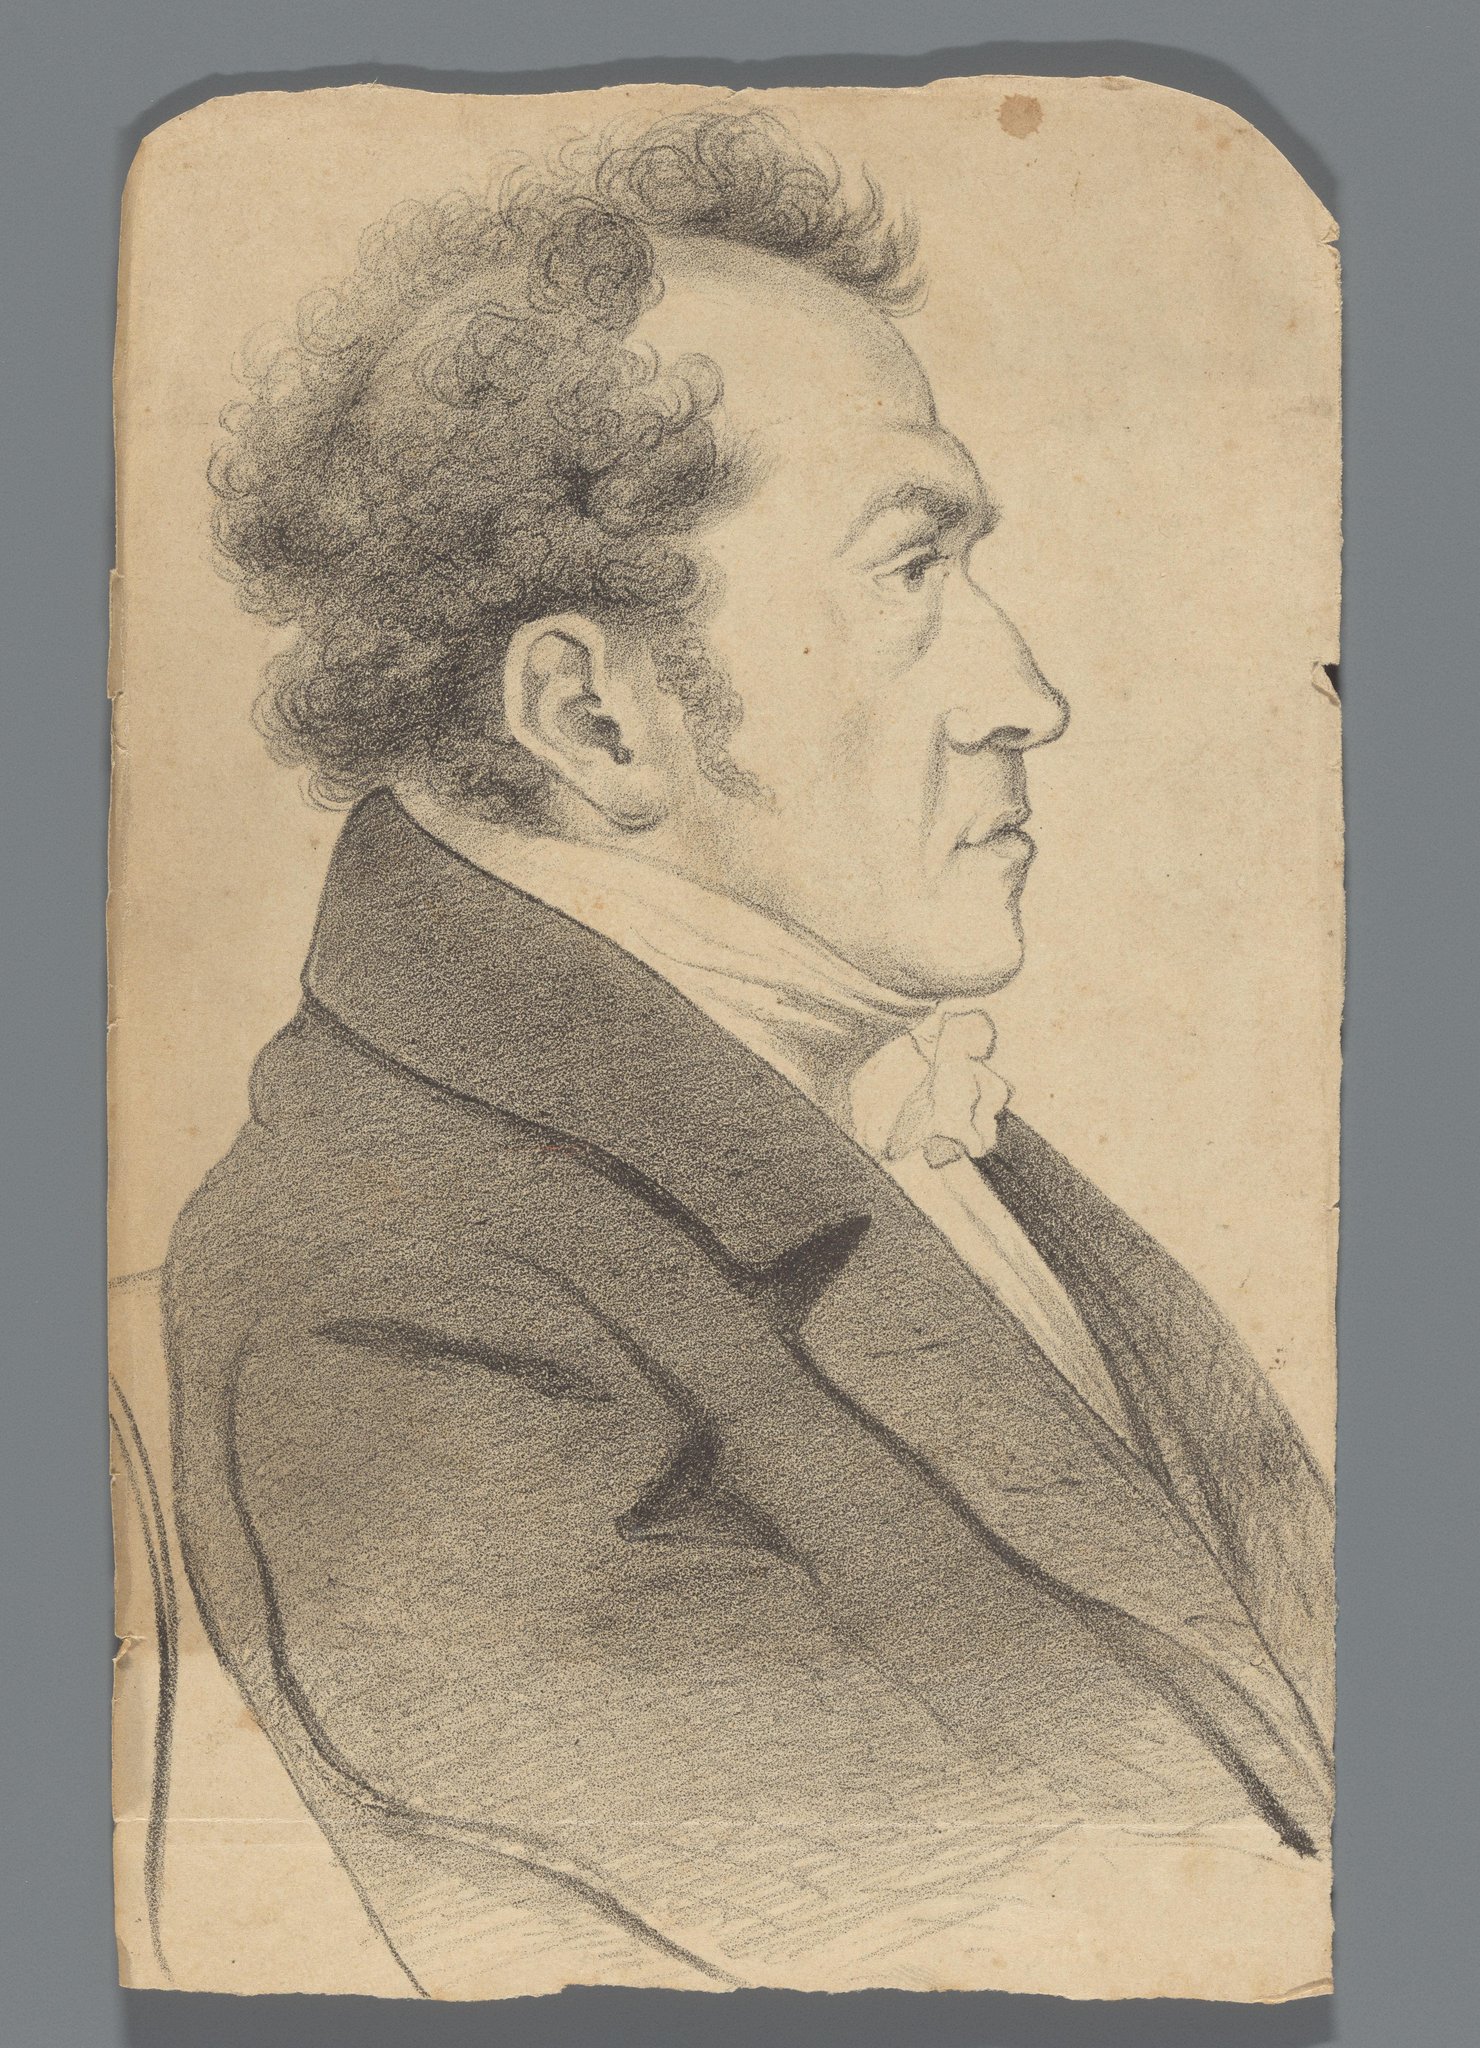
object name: print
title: Portret van een onbekende man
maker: Anonymous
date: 1810-1880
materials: paper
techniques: lithograph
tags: anonymous historical person portrayed